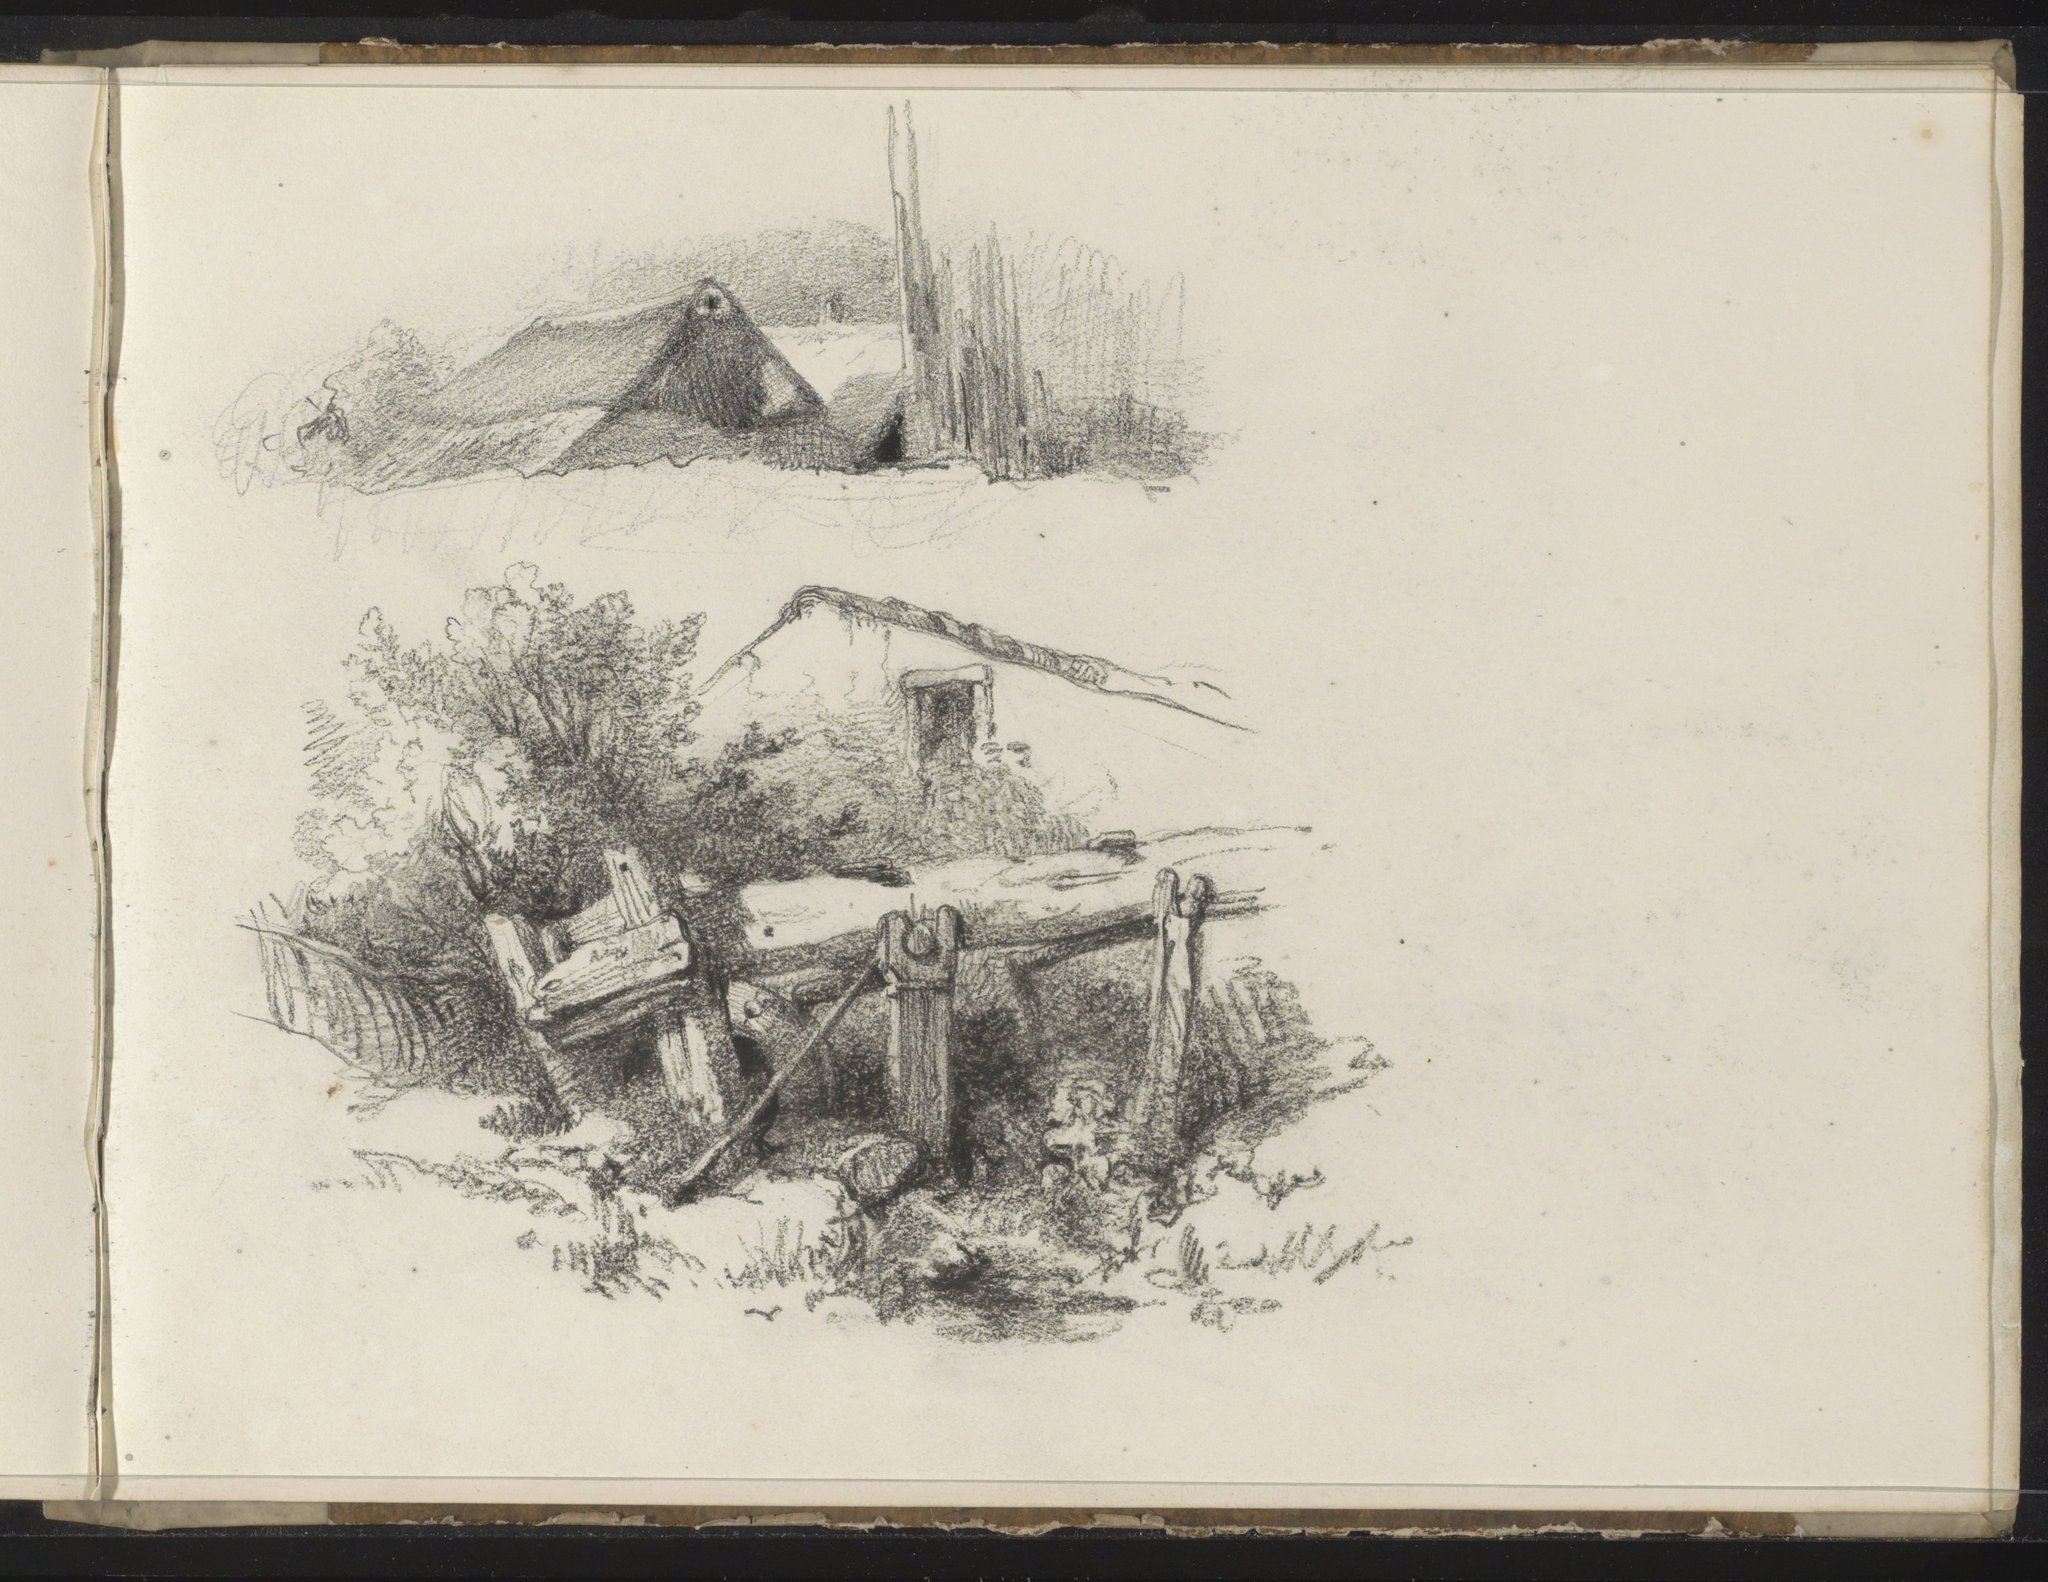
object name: sketchbook leaf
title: Houten werktuig voor een boerderij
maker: maria vos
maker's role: draughtsman, painter, print maker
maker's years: 1824-1906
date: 1834-1906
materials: chalk, paper, pencil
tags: farm (building)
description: Tevens een studie van de boerderij met een puntdak. Blad 34 recto uit een schetsboek met 39 bladen.